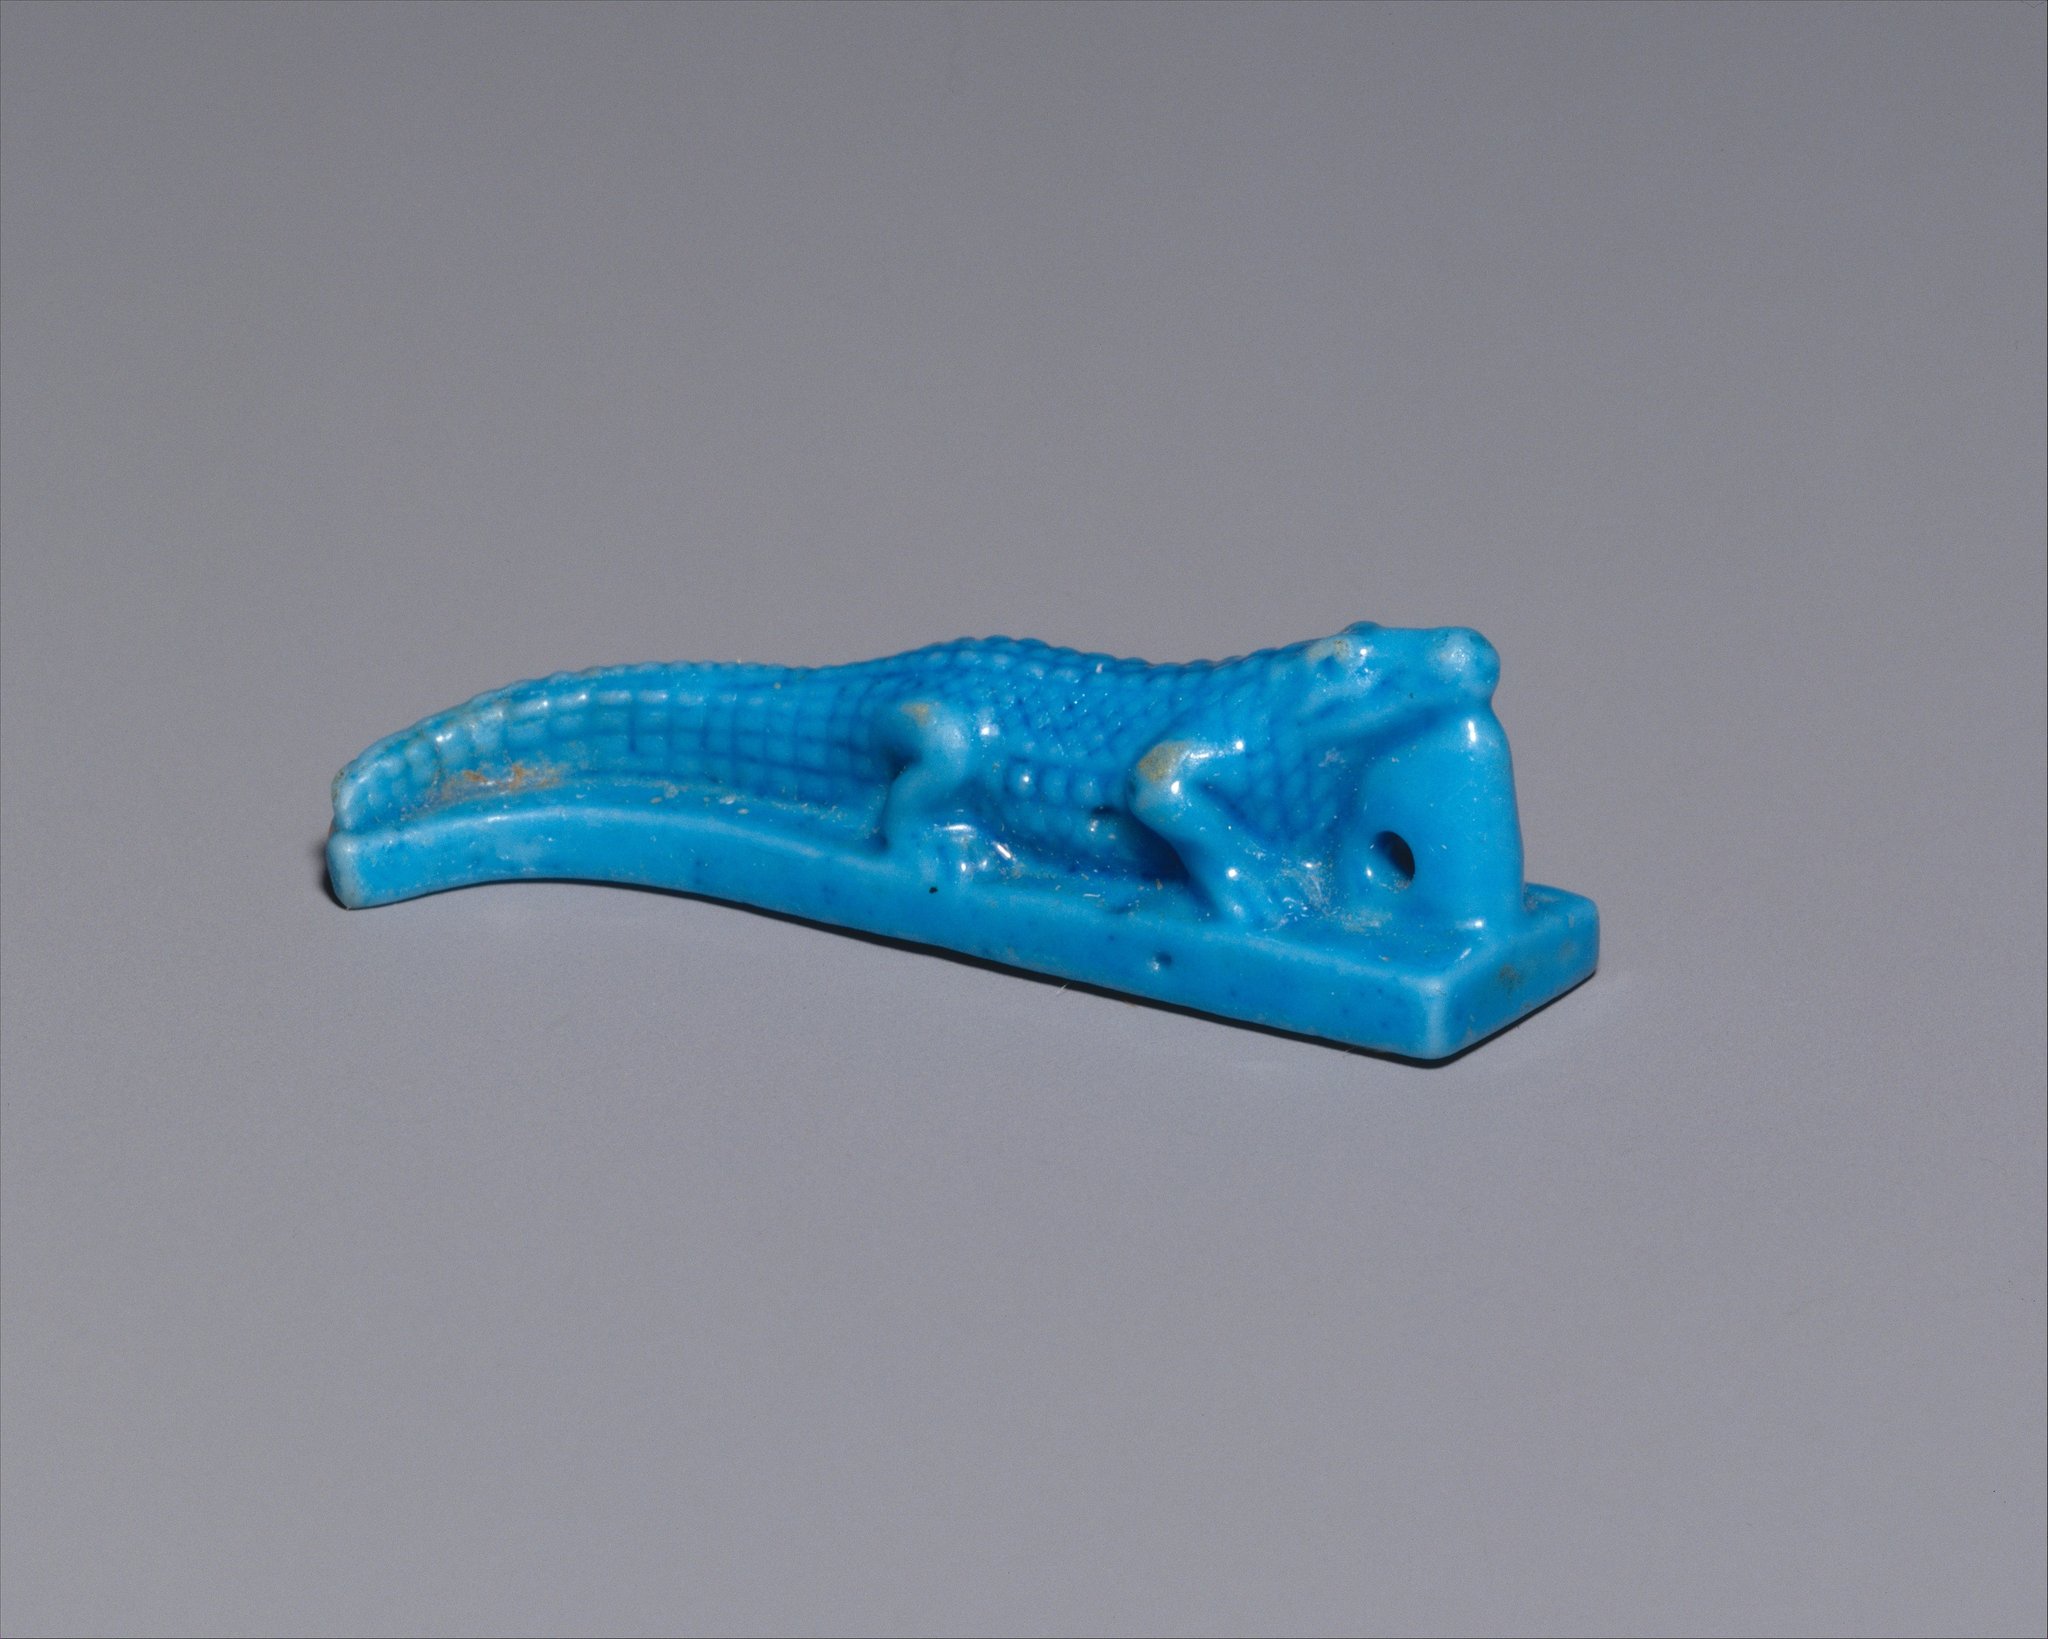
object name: amulet, crocodile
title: Crocodile amulet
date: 304-247 BCE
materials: faience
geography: egypt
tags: crocodiles